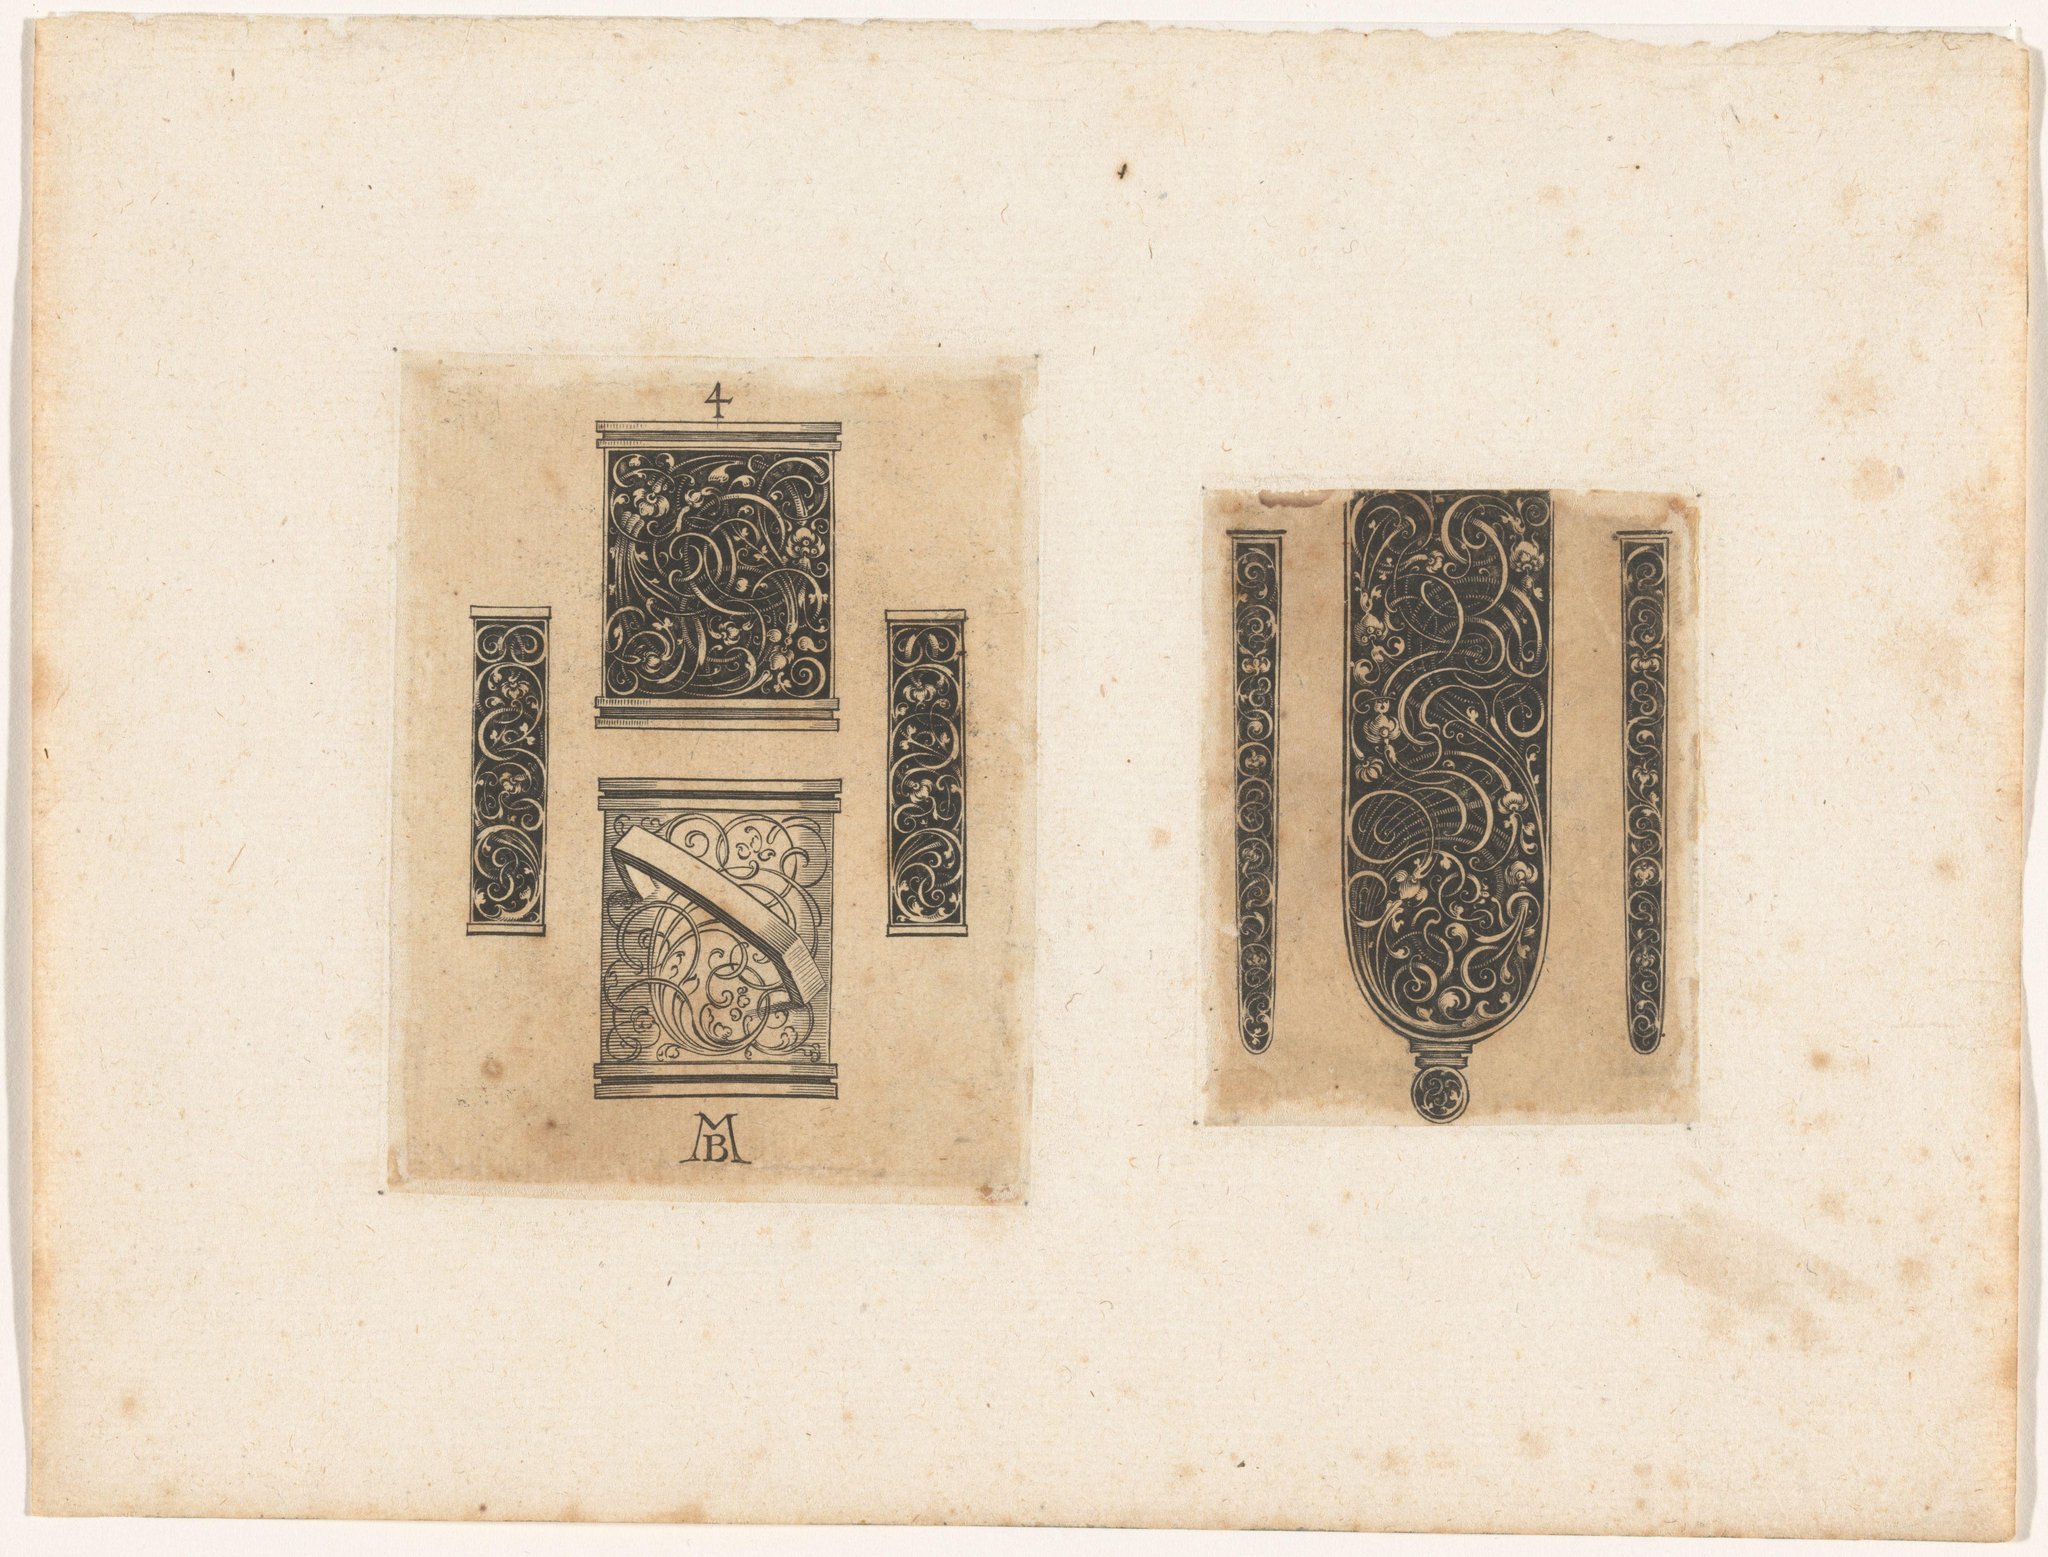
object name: ornament print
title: Drie ontwerpen voor zwaardscheden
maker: michiel le blon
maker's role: print maker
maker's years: 1587-1656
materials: paper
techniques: etching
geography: amsterdam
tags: ornaments ~ art, foliage ~ ornament, hacking and thrusting weapons: sword (+ variant), ornament derived from plant forms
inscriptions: collector's mark: Lugt 2228, collector's mark: Lugt 2760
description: Afgesneden binnen ontwerp: bovenaan hoort nog nummer 3 te staan en onderaan het monogram MB.